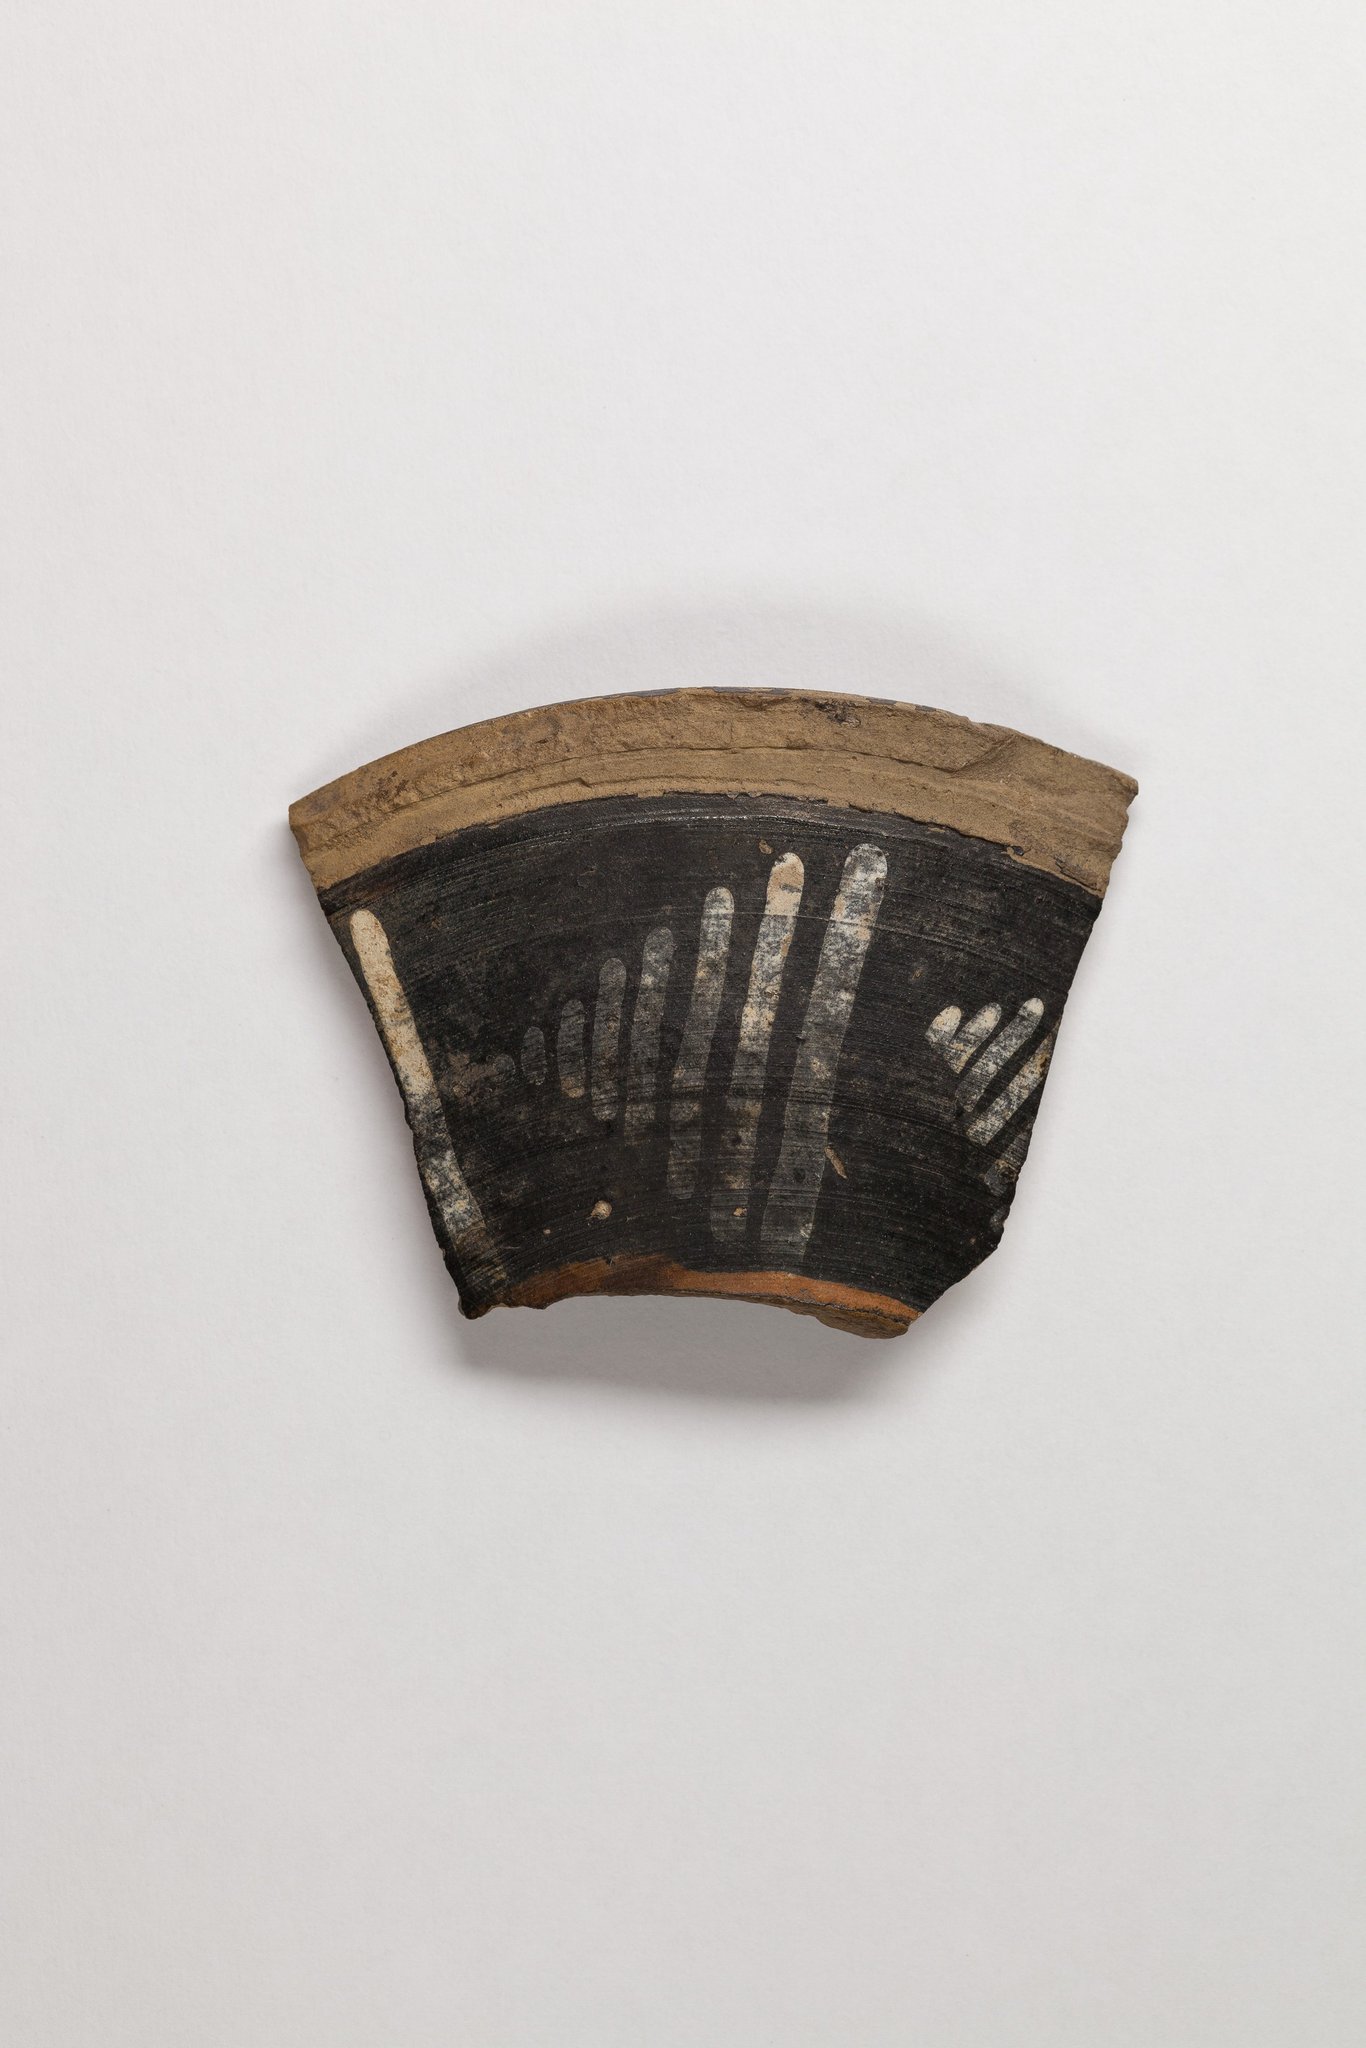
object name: minoan body sherd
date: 1981-1640 BCE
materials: pottery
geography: egypt